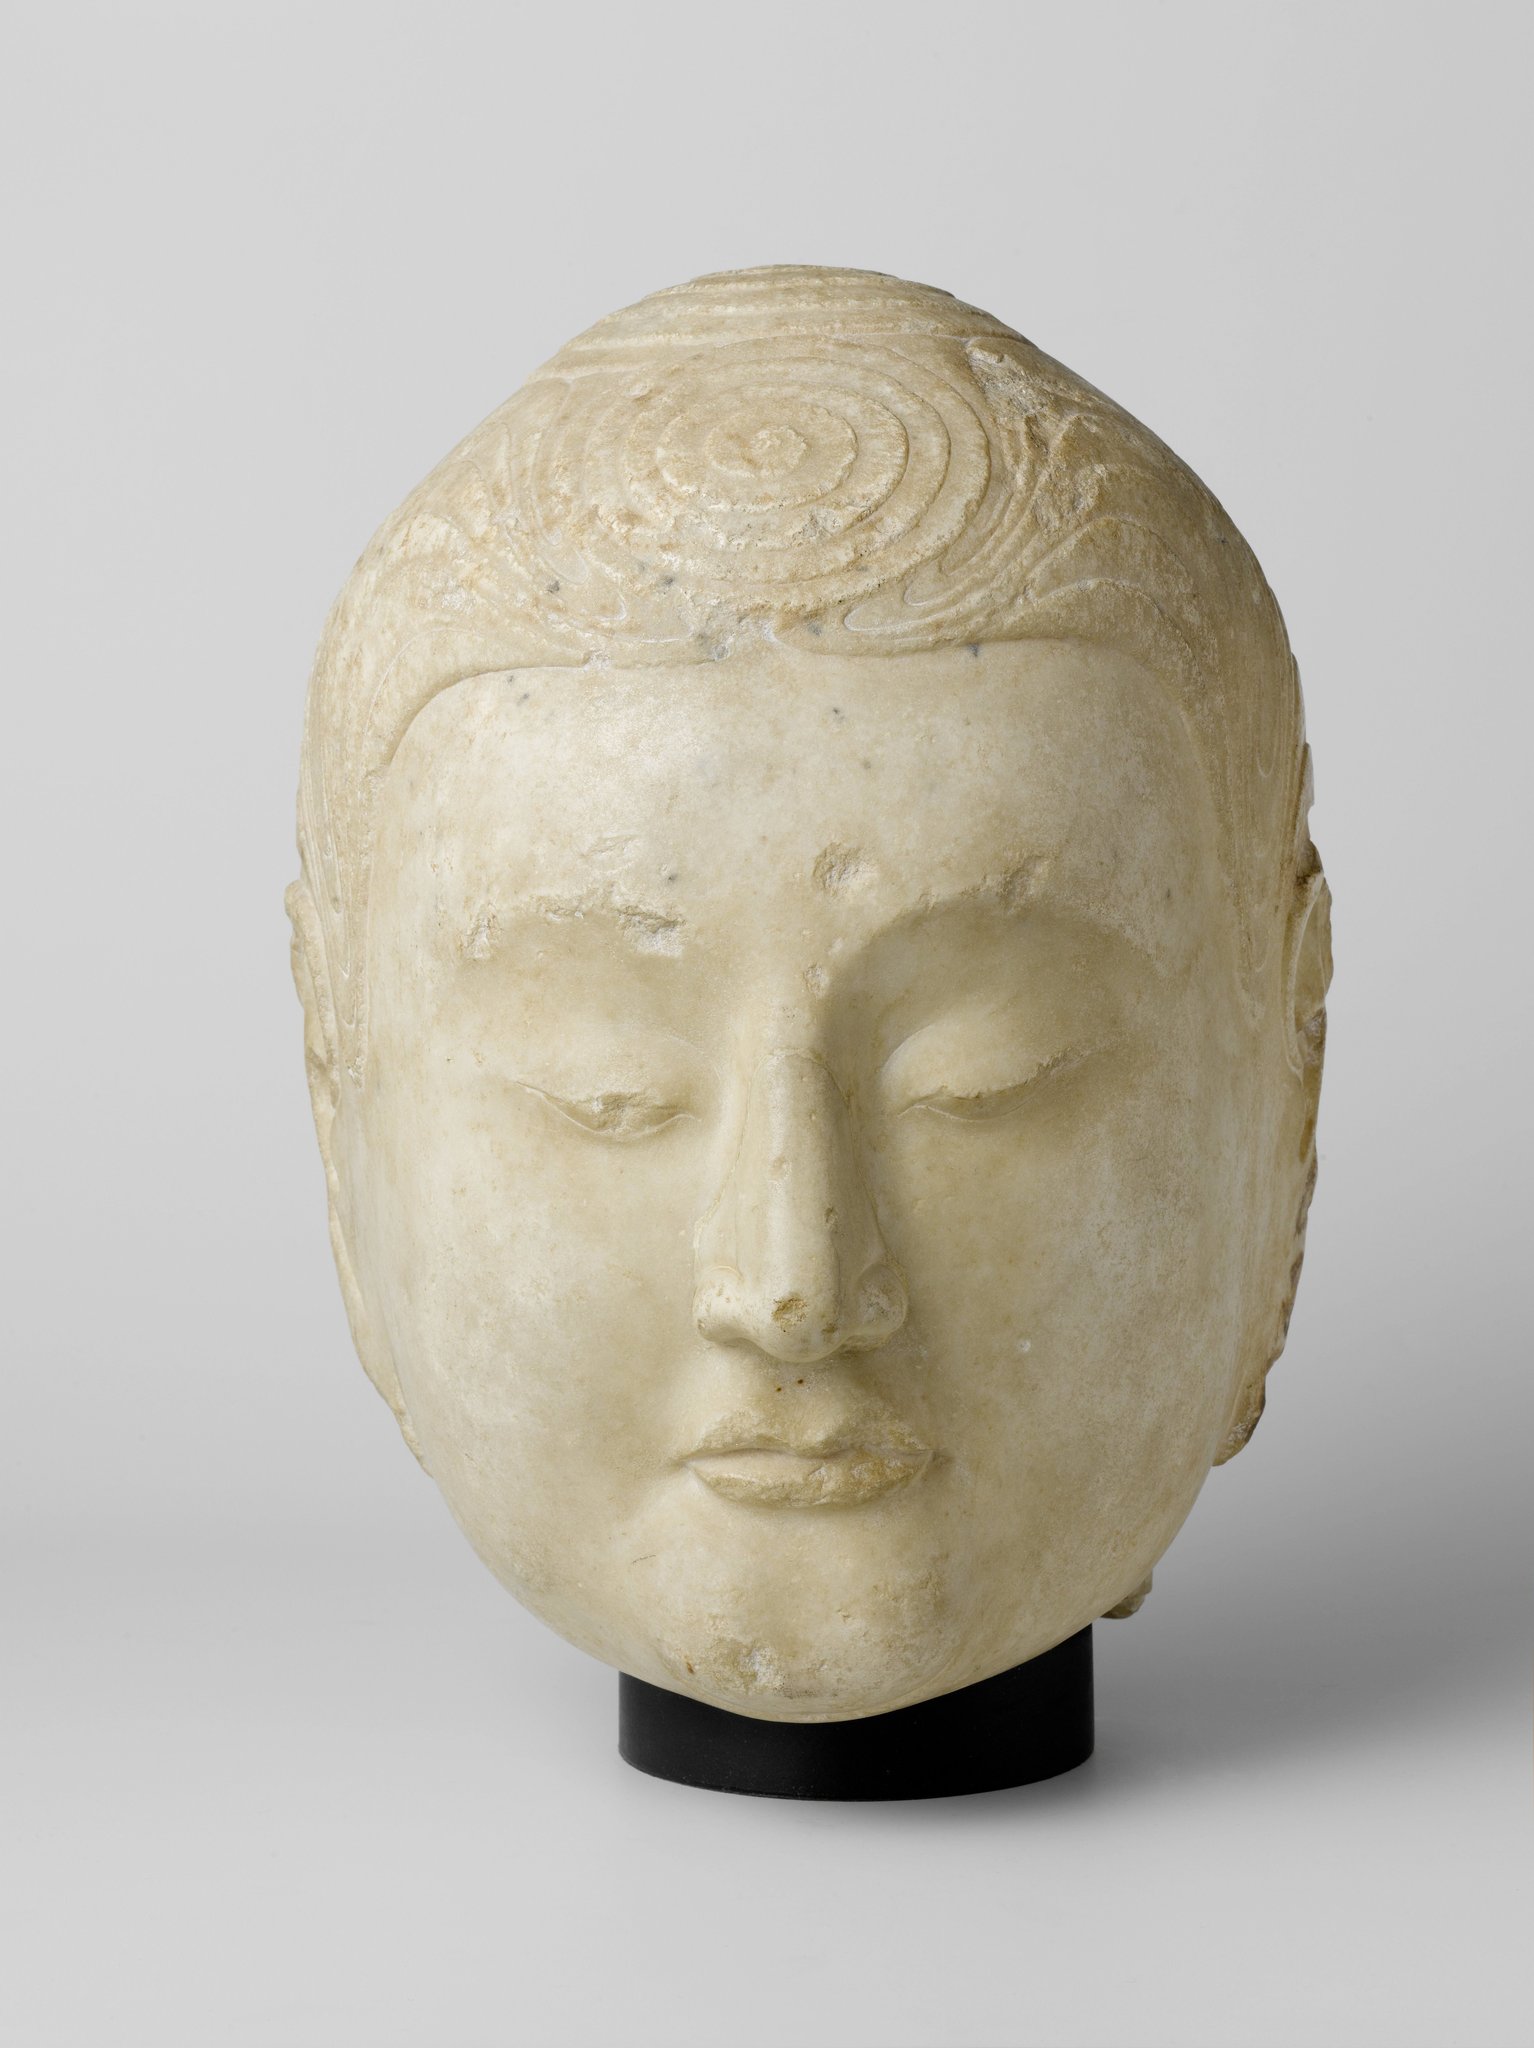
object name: boeddha kop, boeddha beeld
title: Buddha Head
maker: Anonymous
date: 550-650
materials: marble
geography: dingzhou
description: The word buddha means ‘the enlightened one’ in Sanskrit. This head was originally part of a complete body. The marble is smooth and delicately carved, the facial features in particular are elegantly executed. While according to the Chinese Buddhist canon the Buddha has the ‘Thirtytwo Signs of a Great Man,’ not a single sculpture of the Buddha has come down to us displaying all of these bodily features.